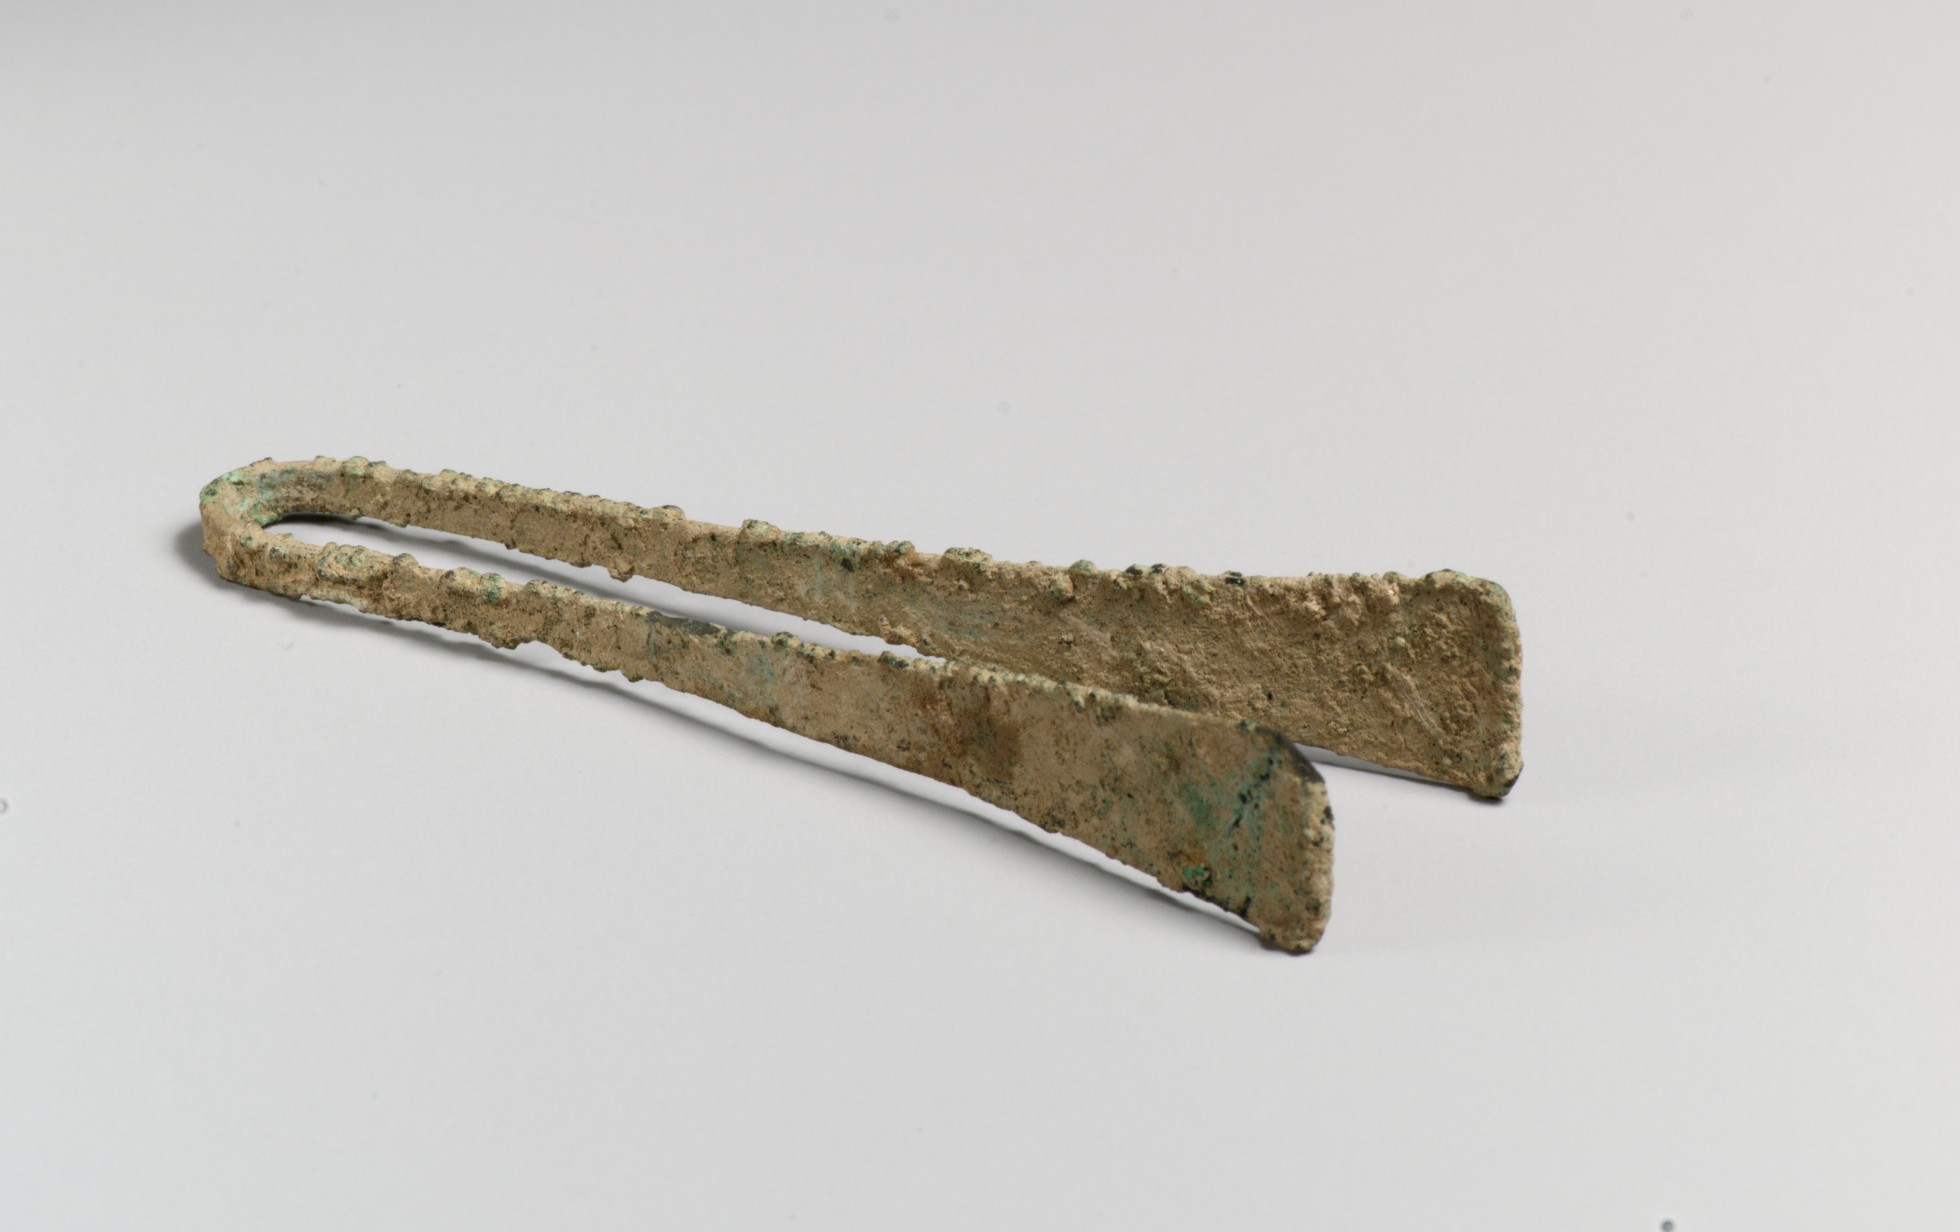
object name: tweezer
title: Bronze tweezers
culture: minoan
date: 2900-1050 BCE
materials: bronze